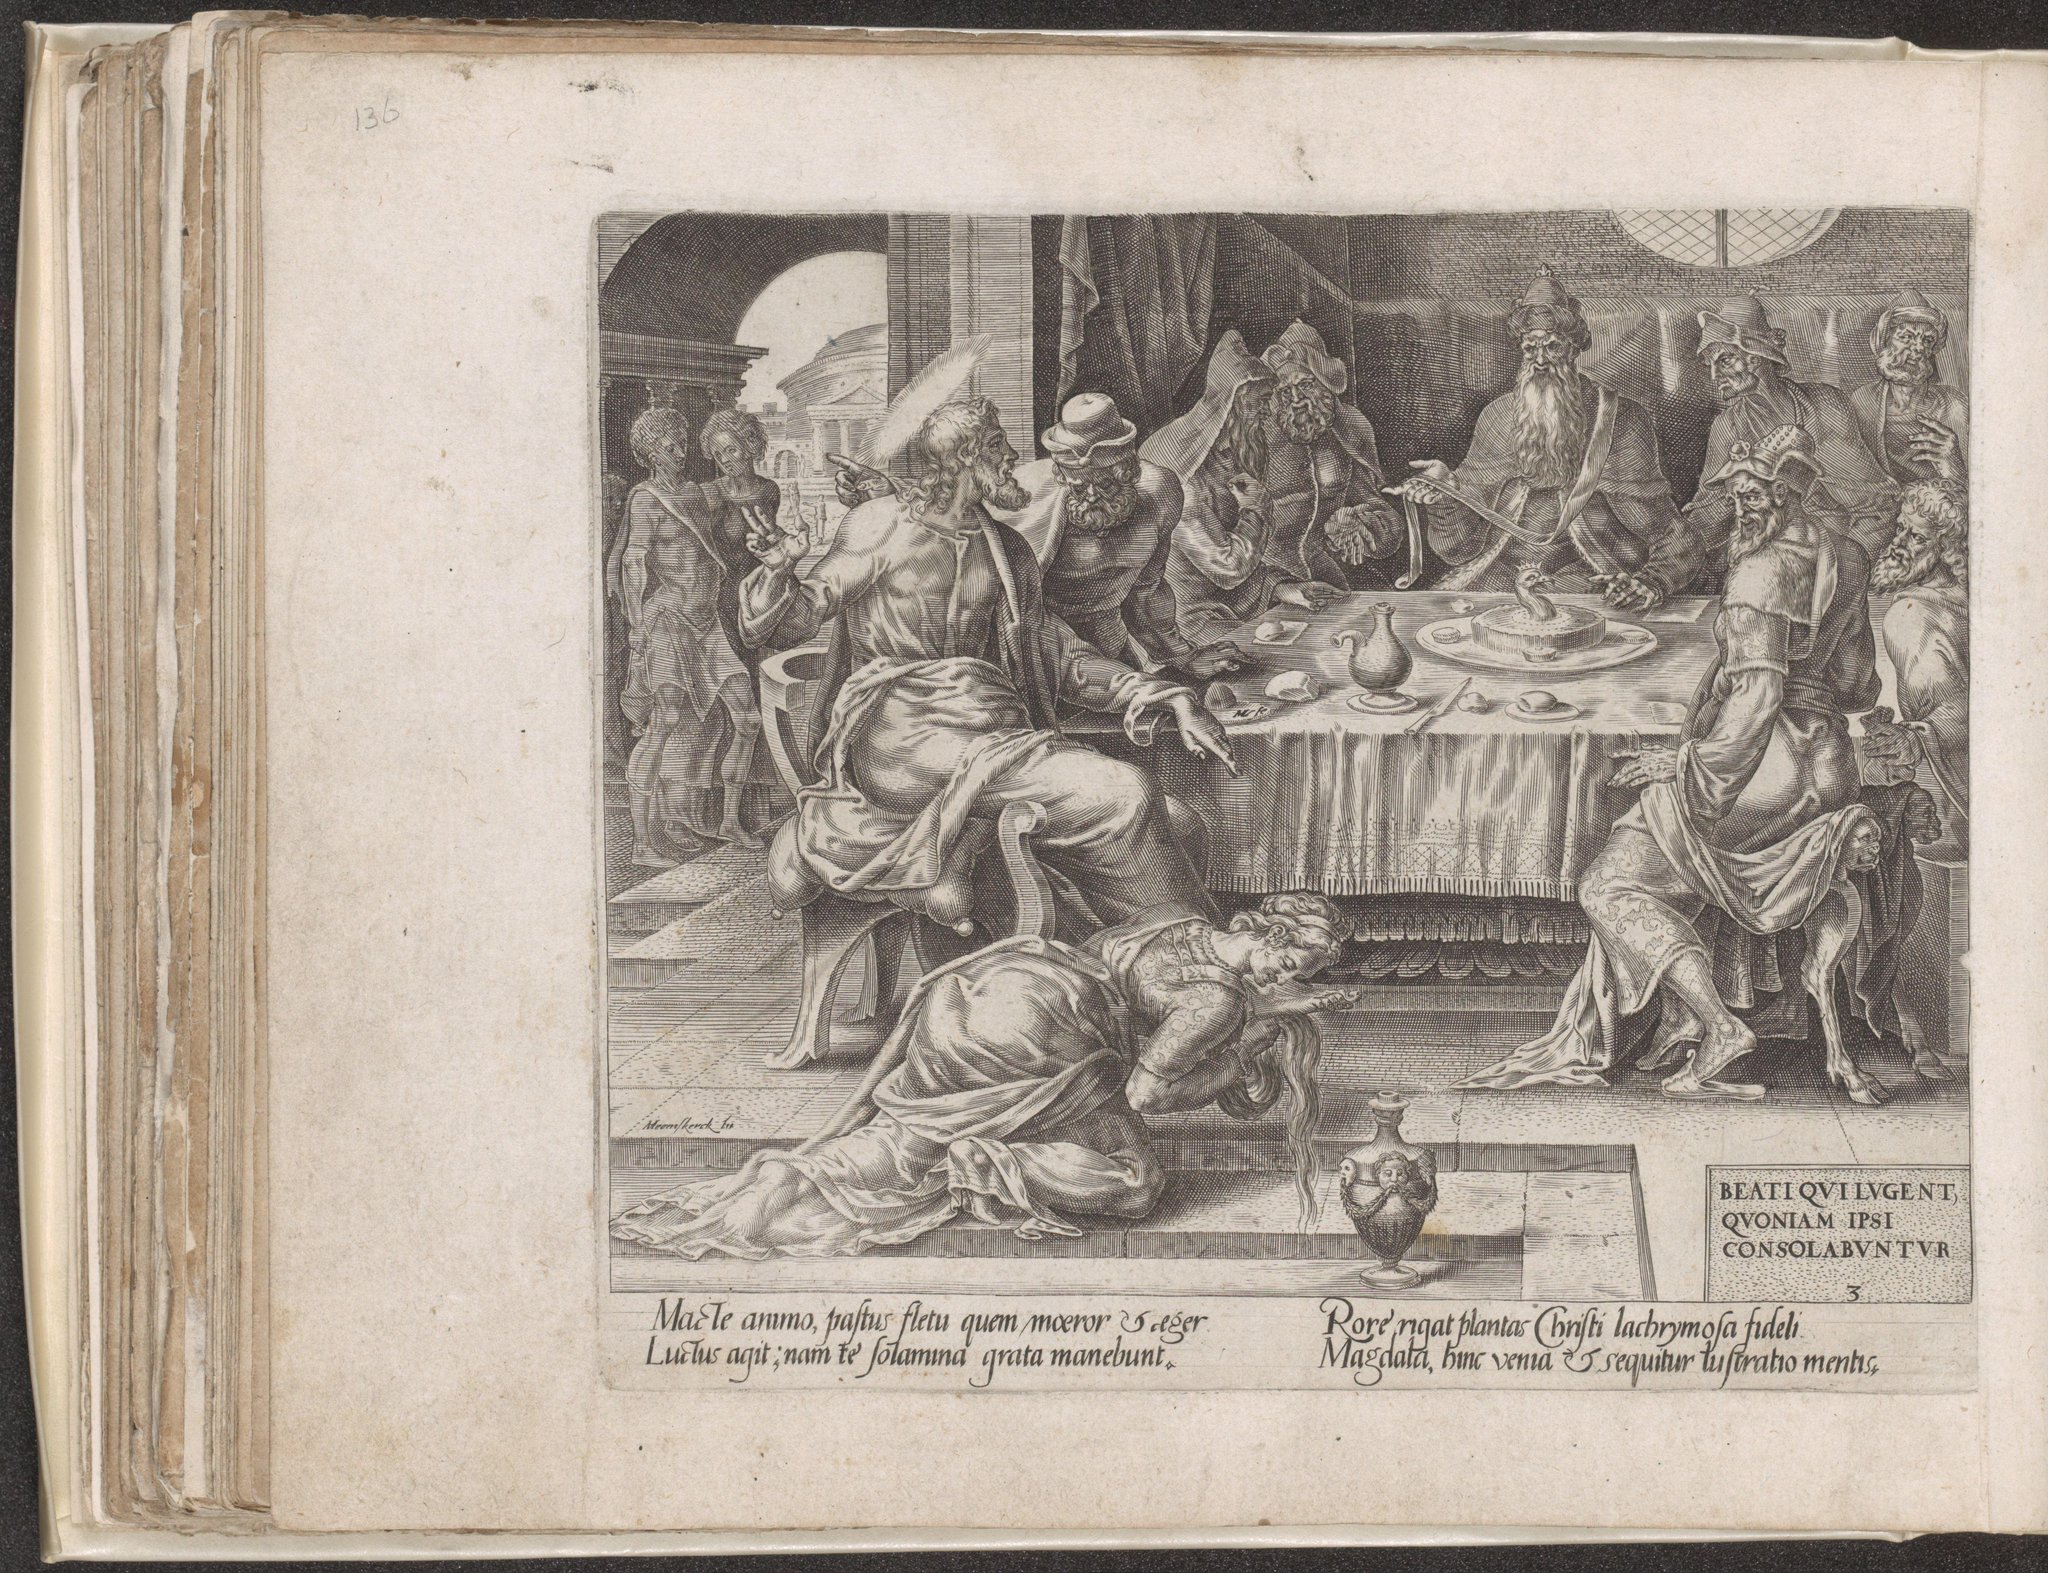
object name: print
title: Christus gezalfd door Maria Magdalena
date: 1564-1568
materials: paper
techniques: engraving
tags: blessed are those who mourn, christ's feet are anointed by mary (magdalene)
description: Christus zit aan tafel te eten in het huis van Simon de Farizeeër. Maria Magdalena knielt op de grond zalft zijn voeten en droogt ze met haar haren. Prent maakt deel uit van een serie over de acht zaligsprekingen van Christus en illustreert de zaligspreking: Zalig de treurenden. In de rechter benedenhoek deze tekst uit Mat. 5:4 in het Latijn. Onderaan in de marge een vers in het Latijn over de zaligspreking en de voorstelling. Deze prent maakt deel uit van een album.